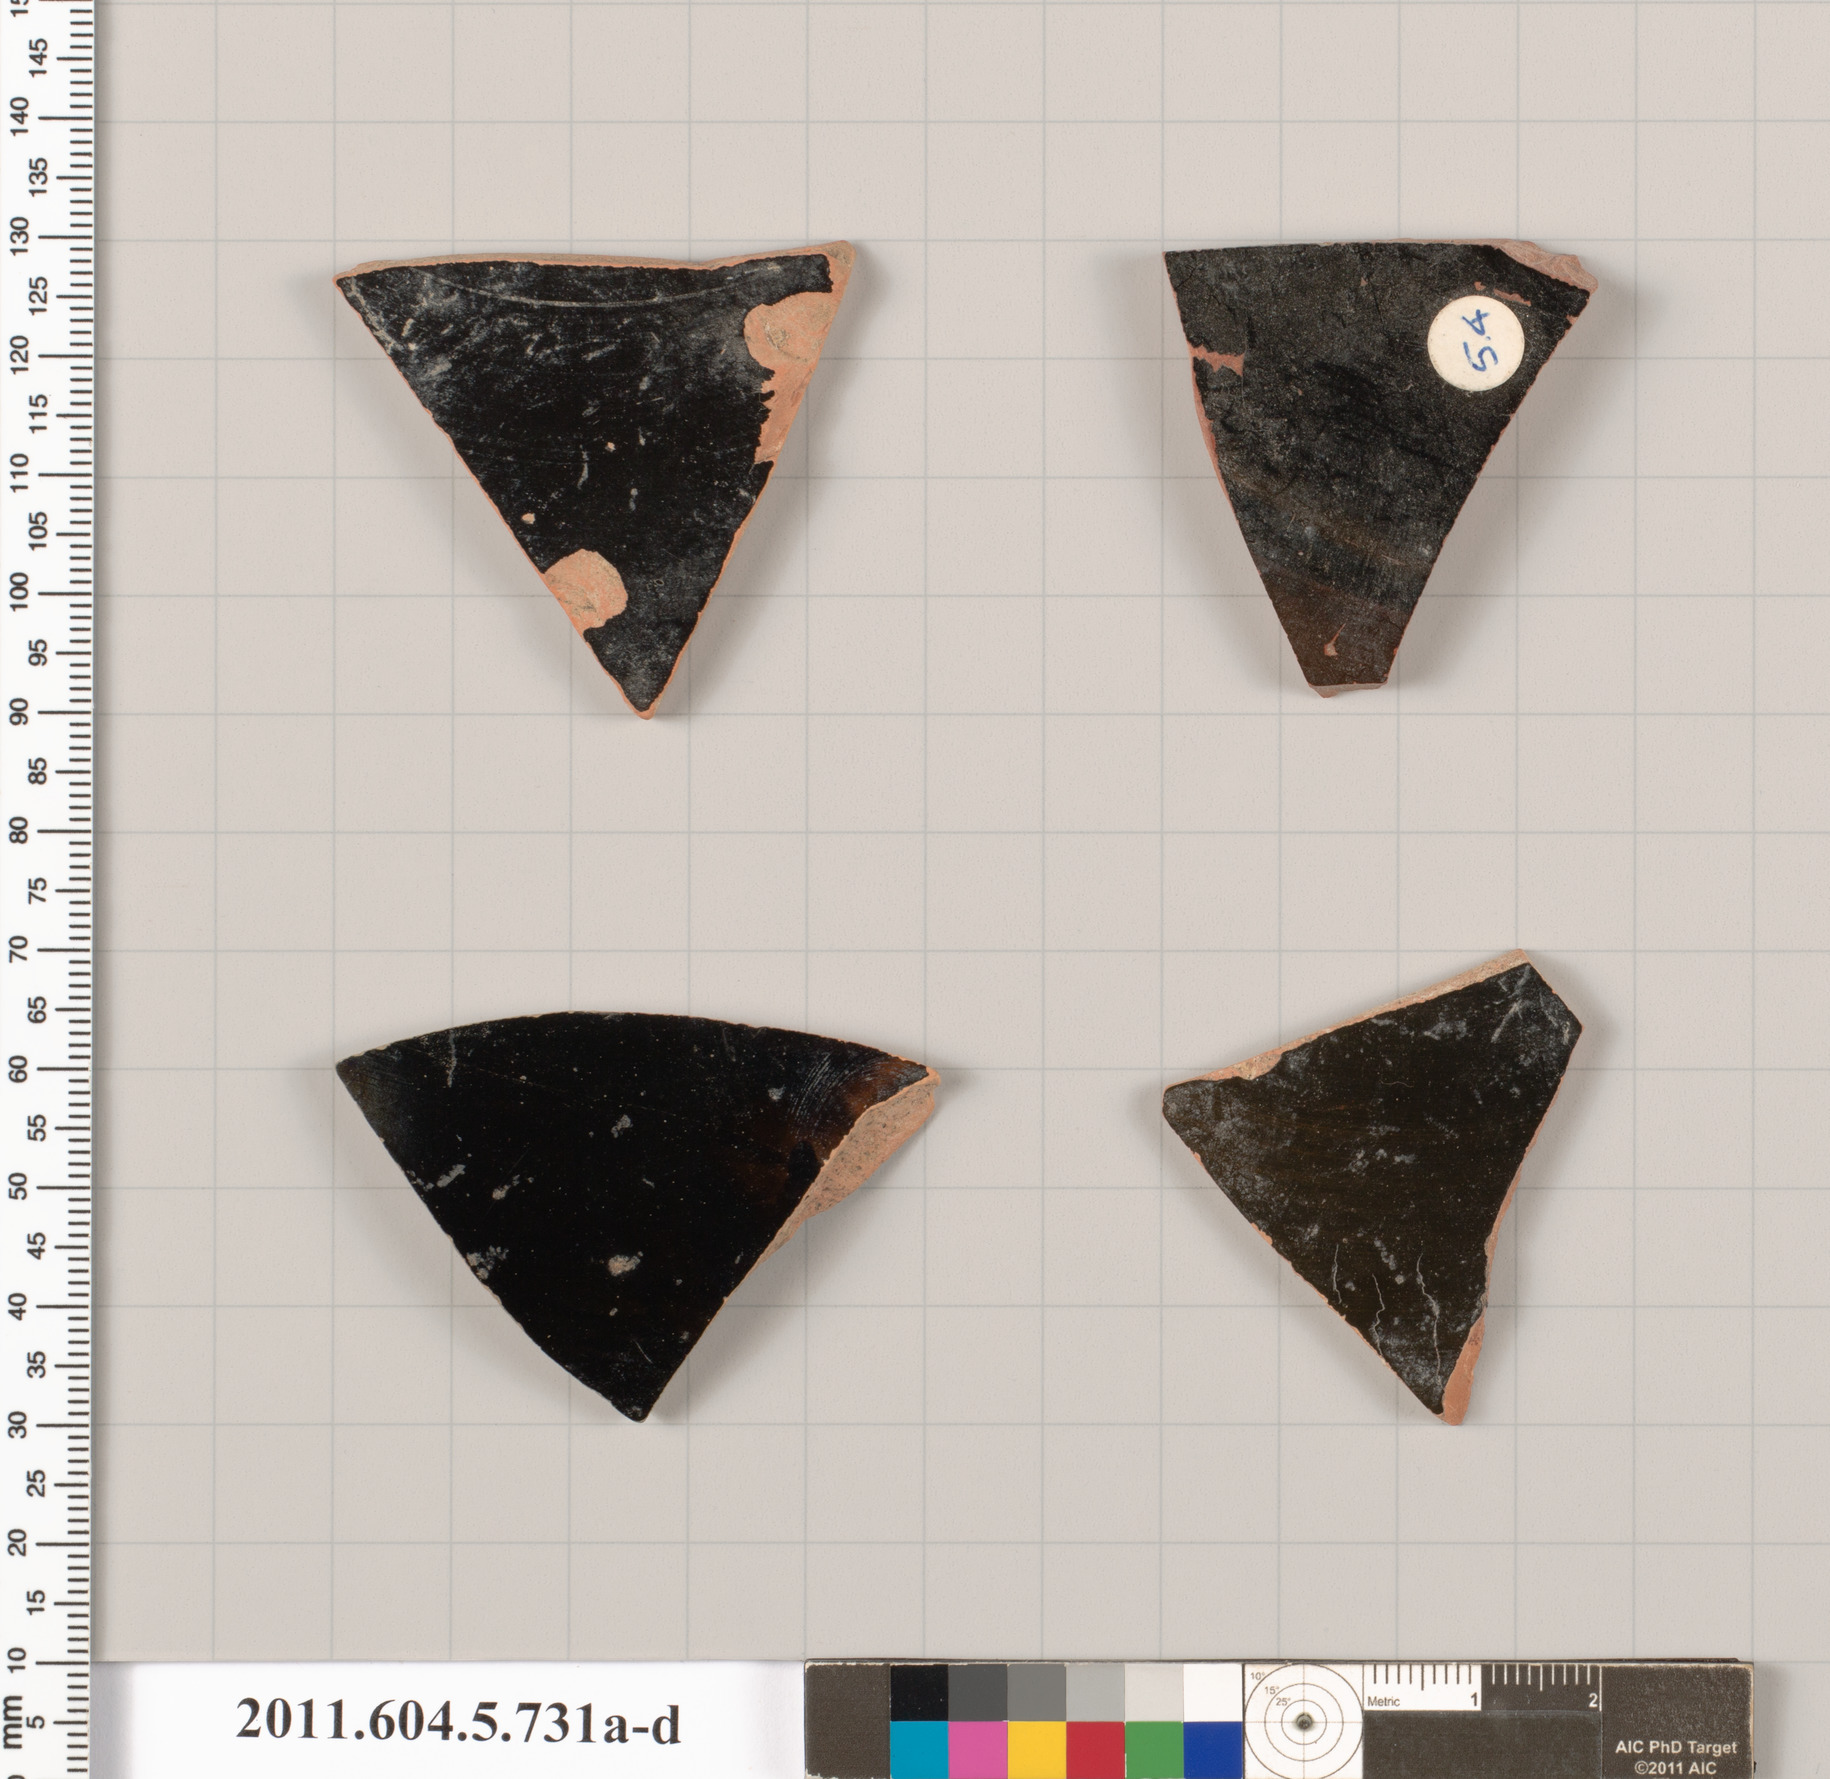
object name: kylix fragment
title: Terracotta fragments of kylikes (drinking cups)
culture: greek, attic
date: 600-401 BCE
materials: terracotta